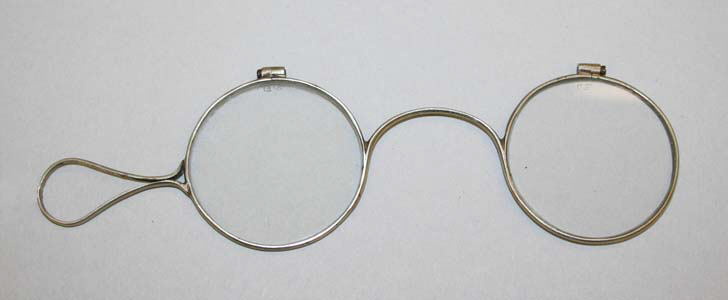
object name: eyeglass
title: Eyeglasses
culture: european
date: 1801-1825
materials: metal